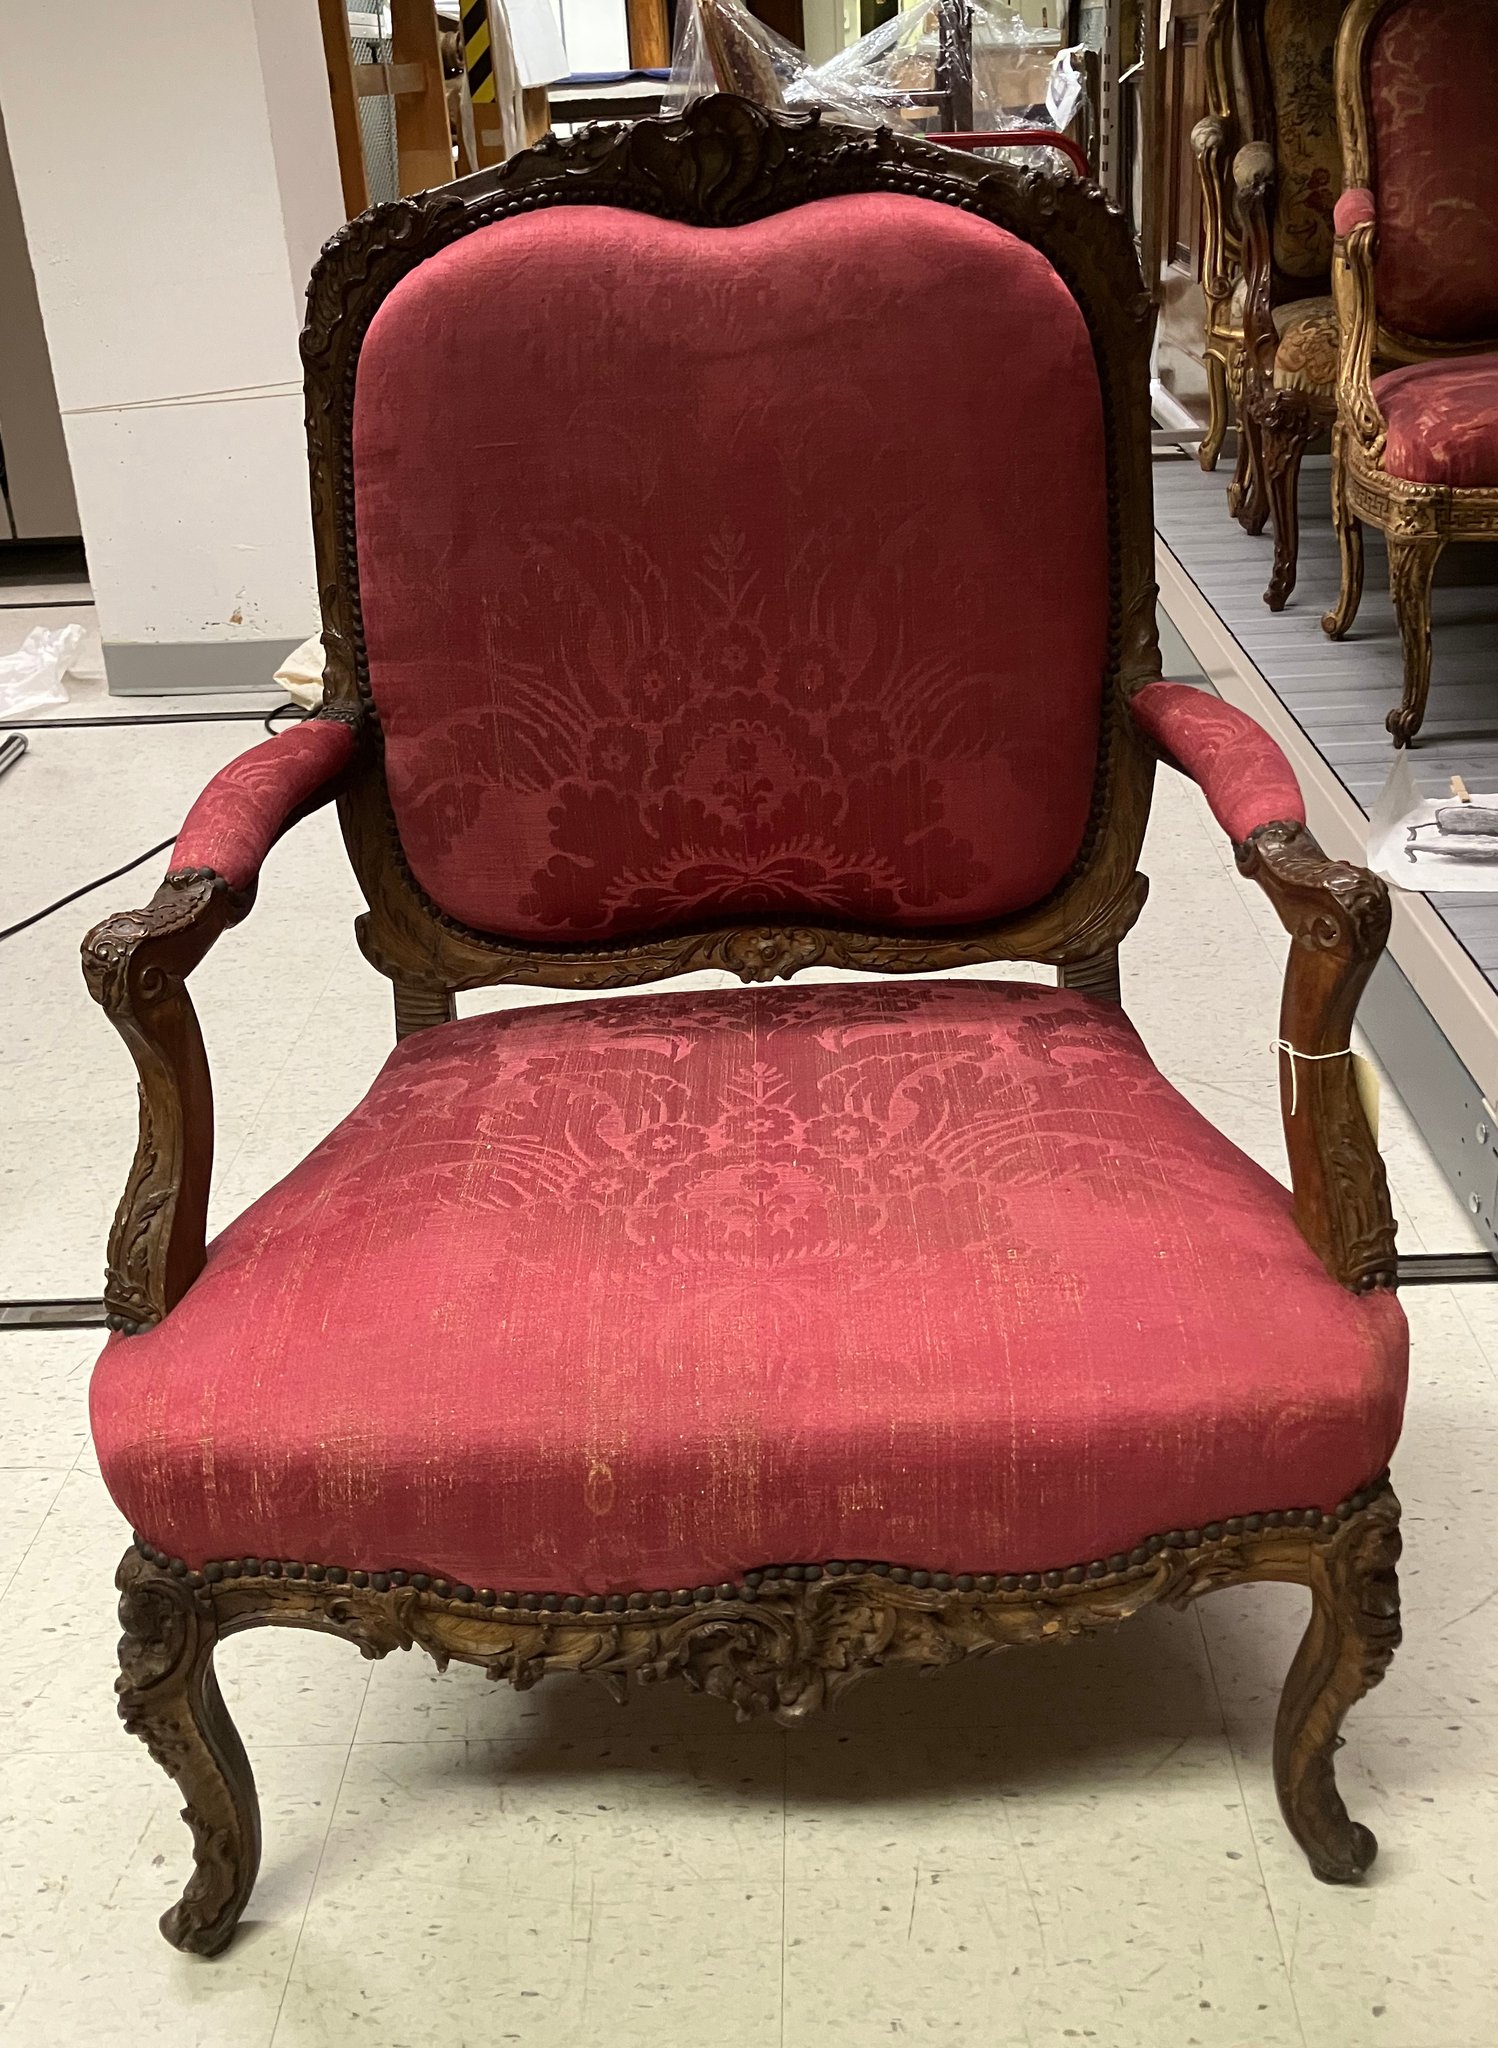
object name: armchair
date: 1701-1800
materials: wood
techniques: carving